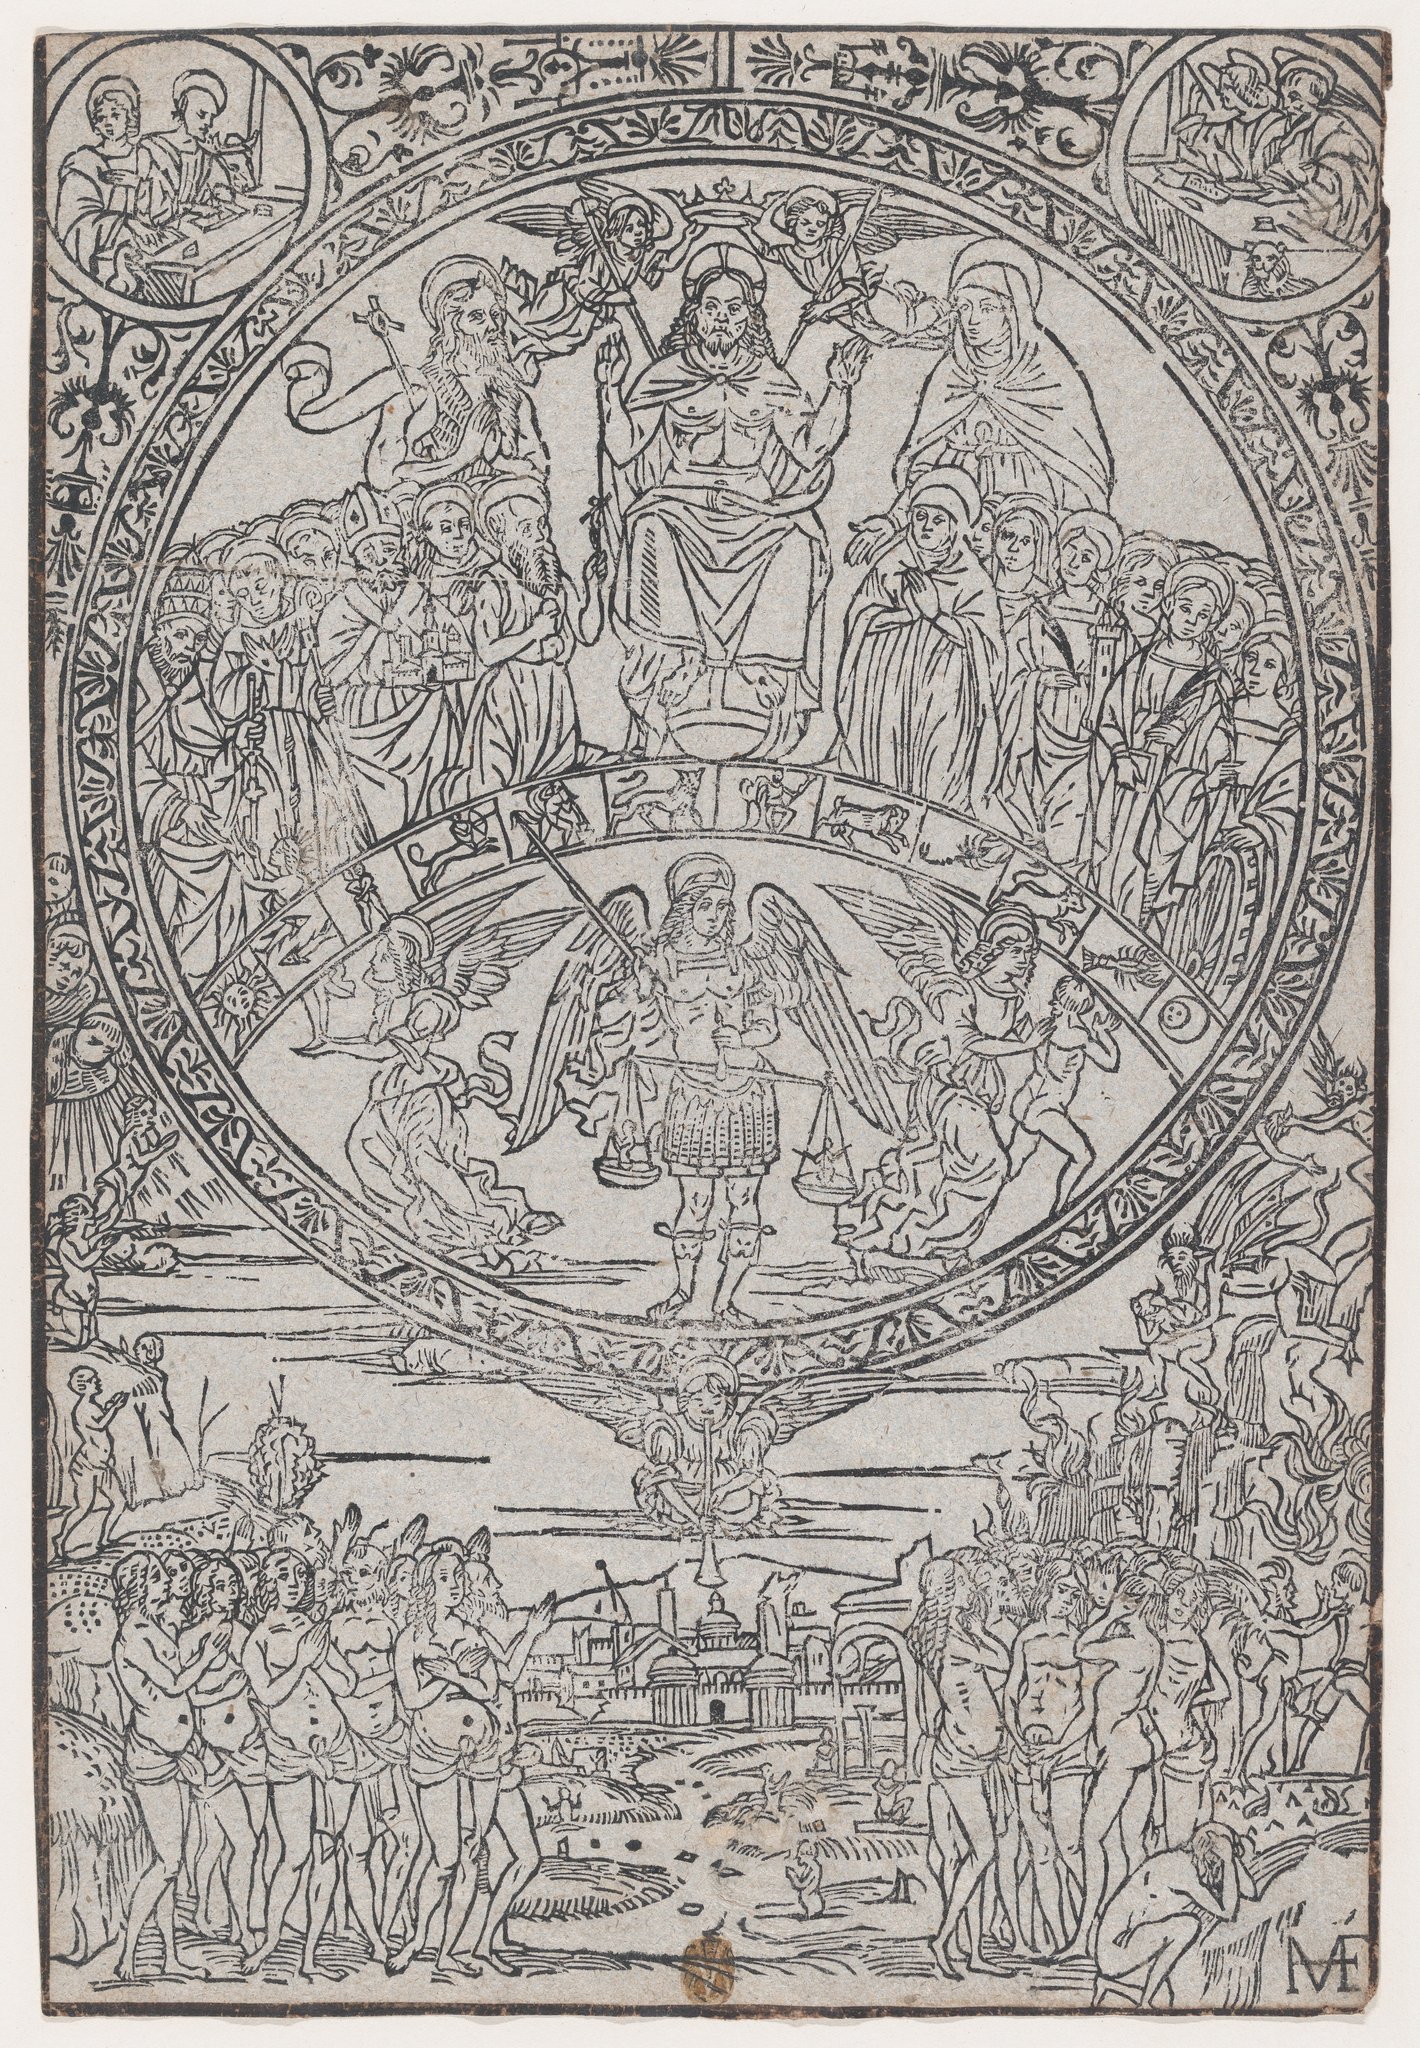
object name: print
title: The Last Judgment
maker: anonymous, italian, 15th to 16th century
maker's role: artist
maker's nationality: italian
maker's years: 1400-1700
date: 1401-1500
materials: ink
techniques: woodcut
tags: angels,last judgement